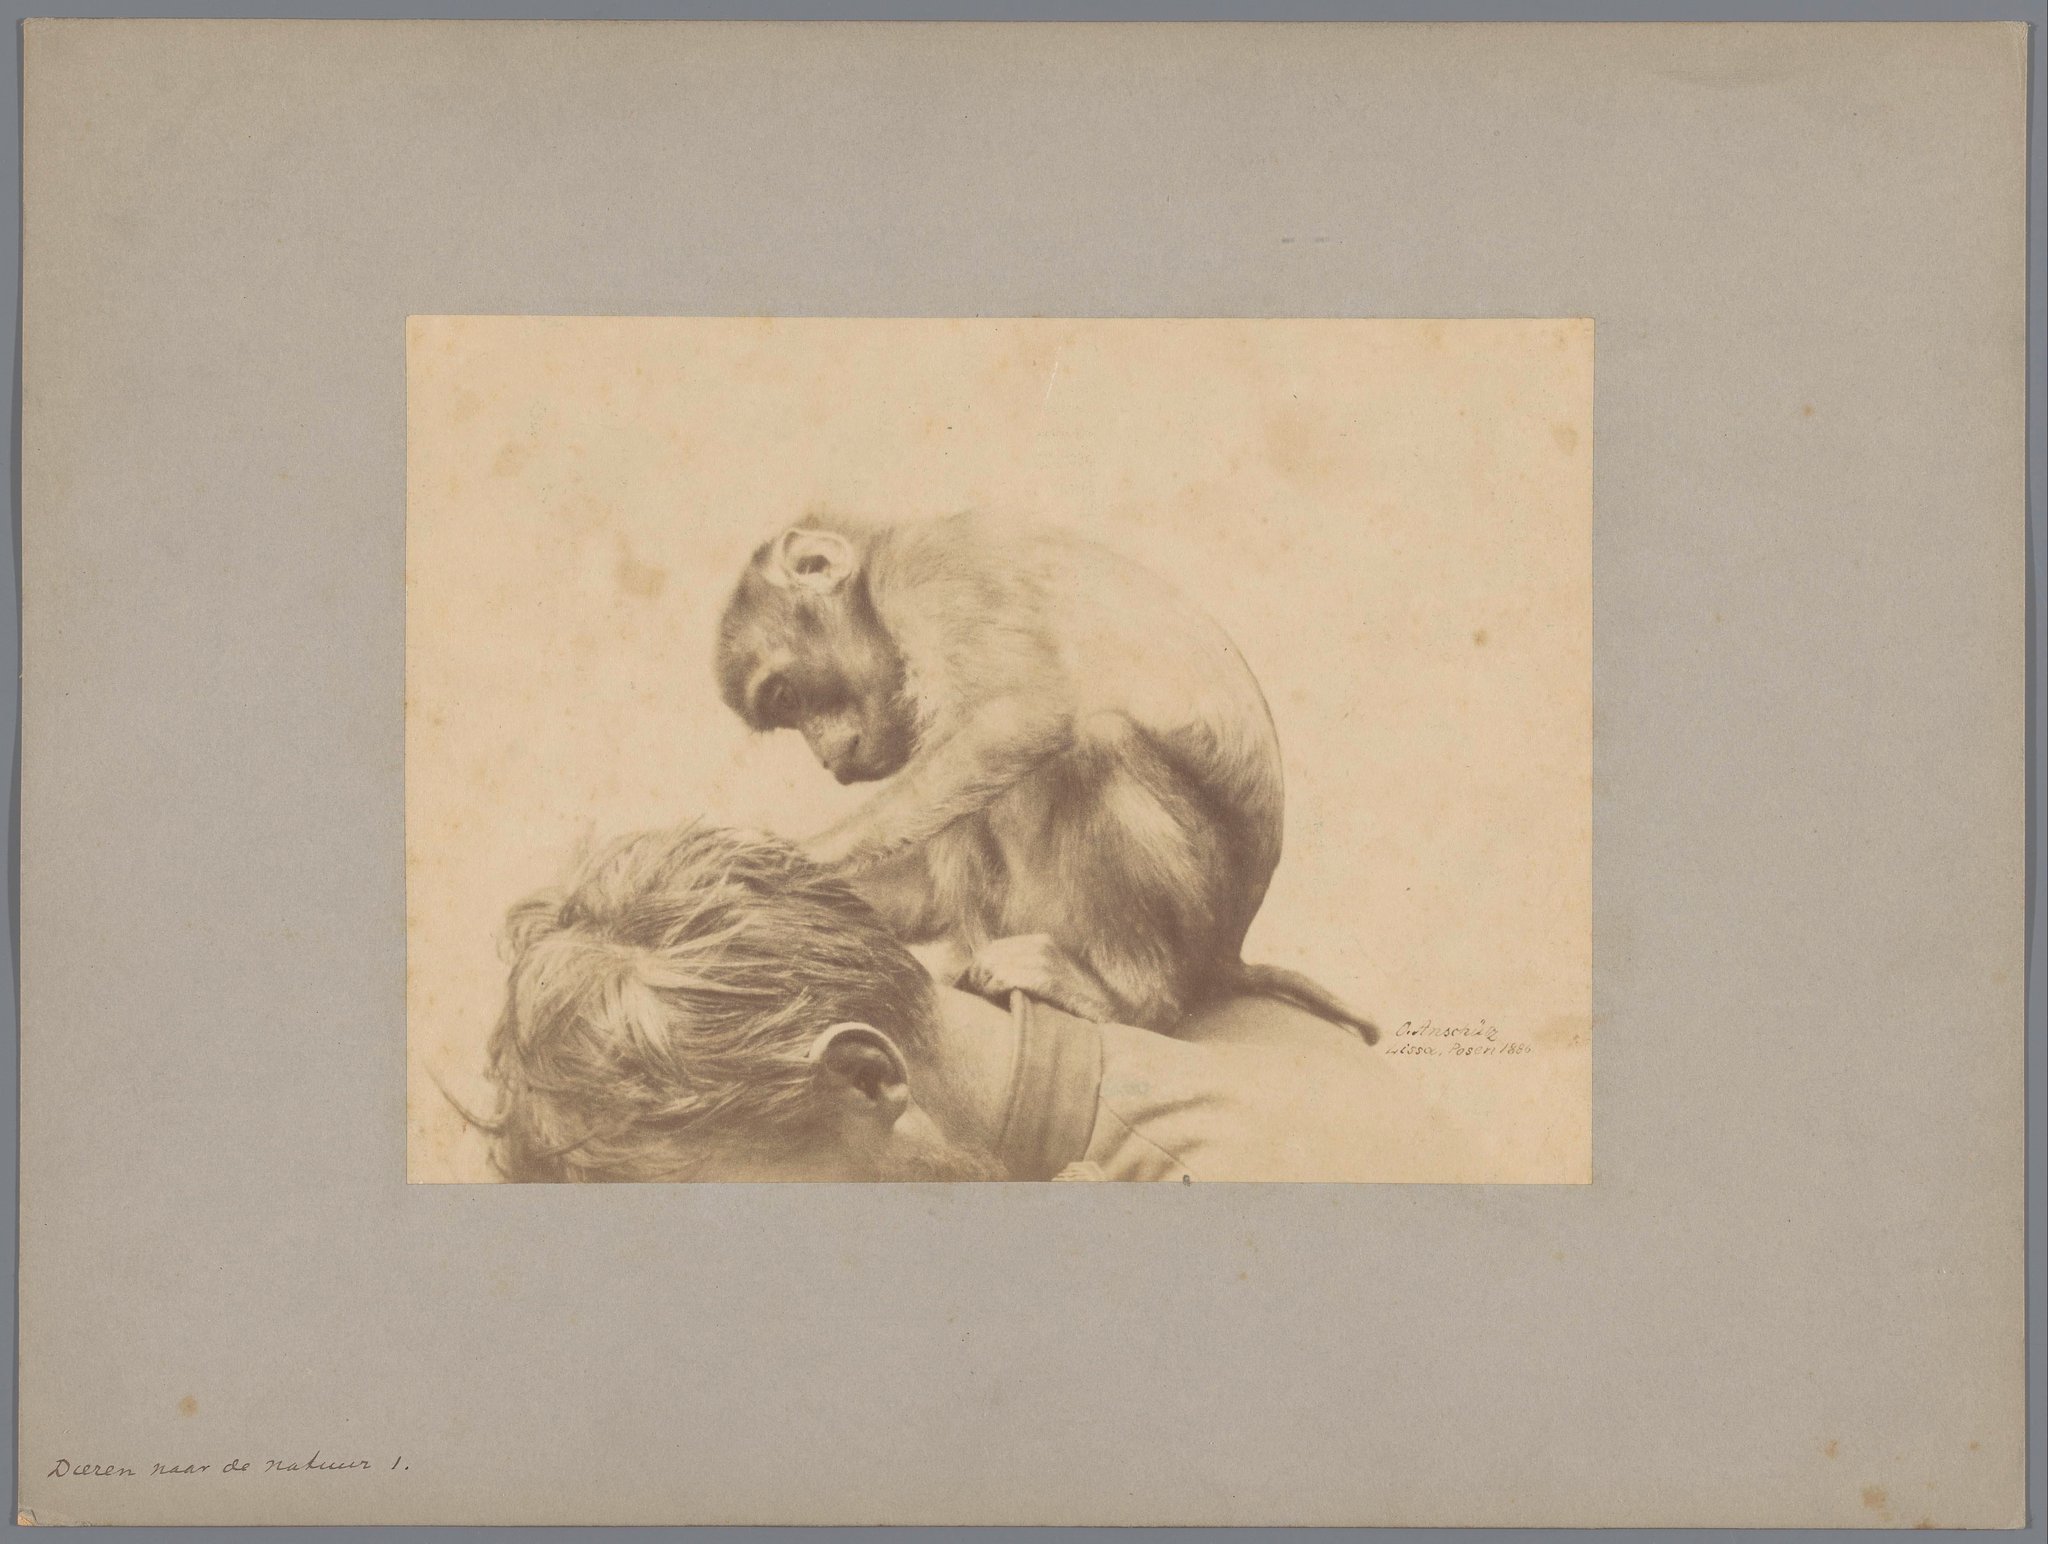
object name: photograph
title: Aap die het hoofd van een mens vlooit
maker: ottomar anschütz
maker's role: fotograaf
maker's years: 1846-1907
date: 1886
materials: cardboard, photographic support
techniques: albumen print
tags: monkeys, apes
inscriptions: collector's mark: ‘RIJKS-NORMAALSCHOOL-VOOR-TEEKENONDERWIJZERS-AMSTERDAM’, name: ‘O. Anschütz Lissa, Posen 1886’